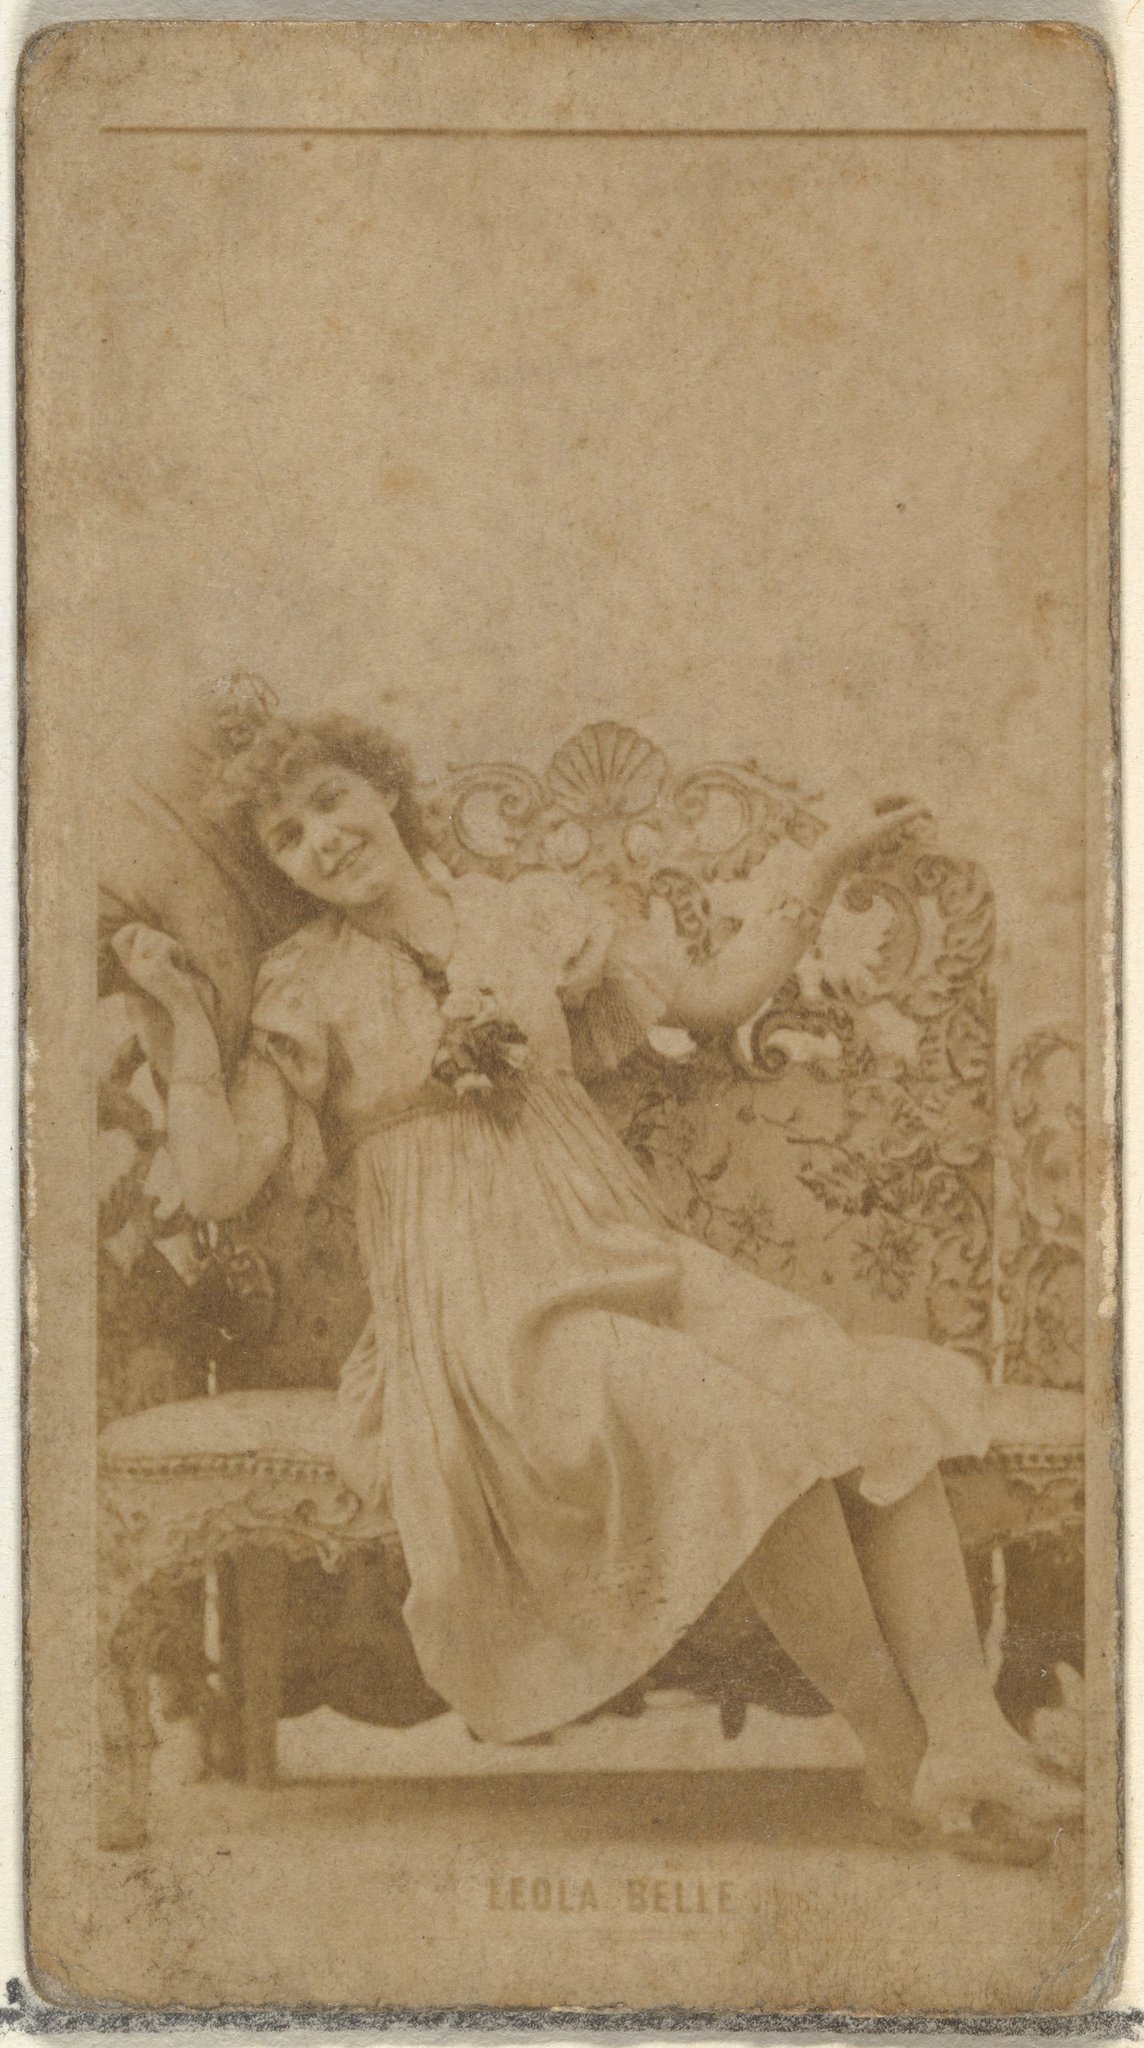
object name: photograph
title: Leola Belle, from the Actors and Actresses series (N145-8) issued by Duke Sons & Co. to promote Duke Cigarettes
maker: w. duke, sons & co.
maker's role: publisher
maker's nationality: american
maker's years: 1870-1920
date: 1891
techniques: albumen silver print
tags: portraits,women,actresses